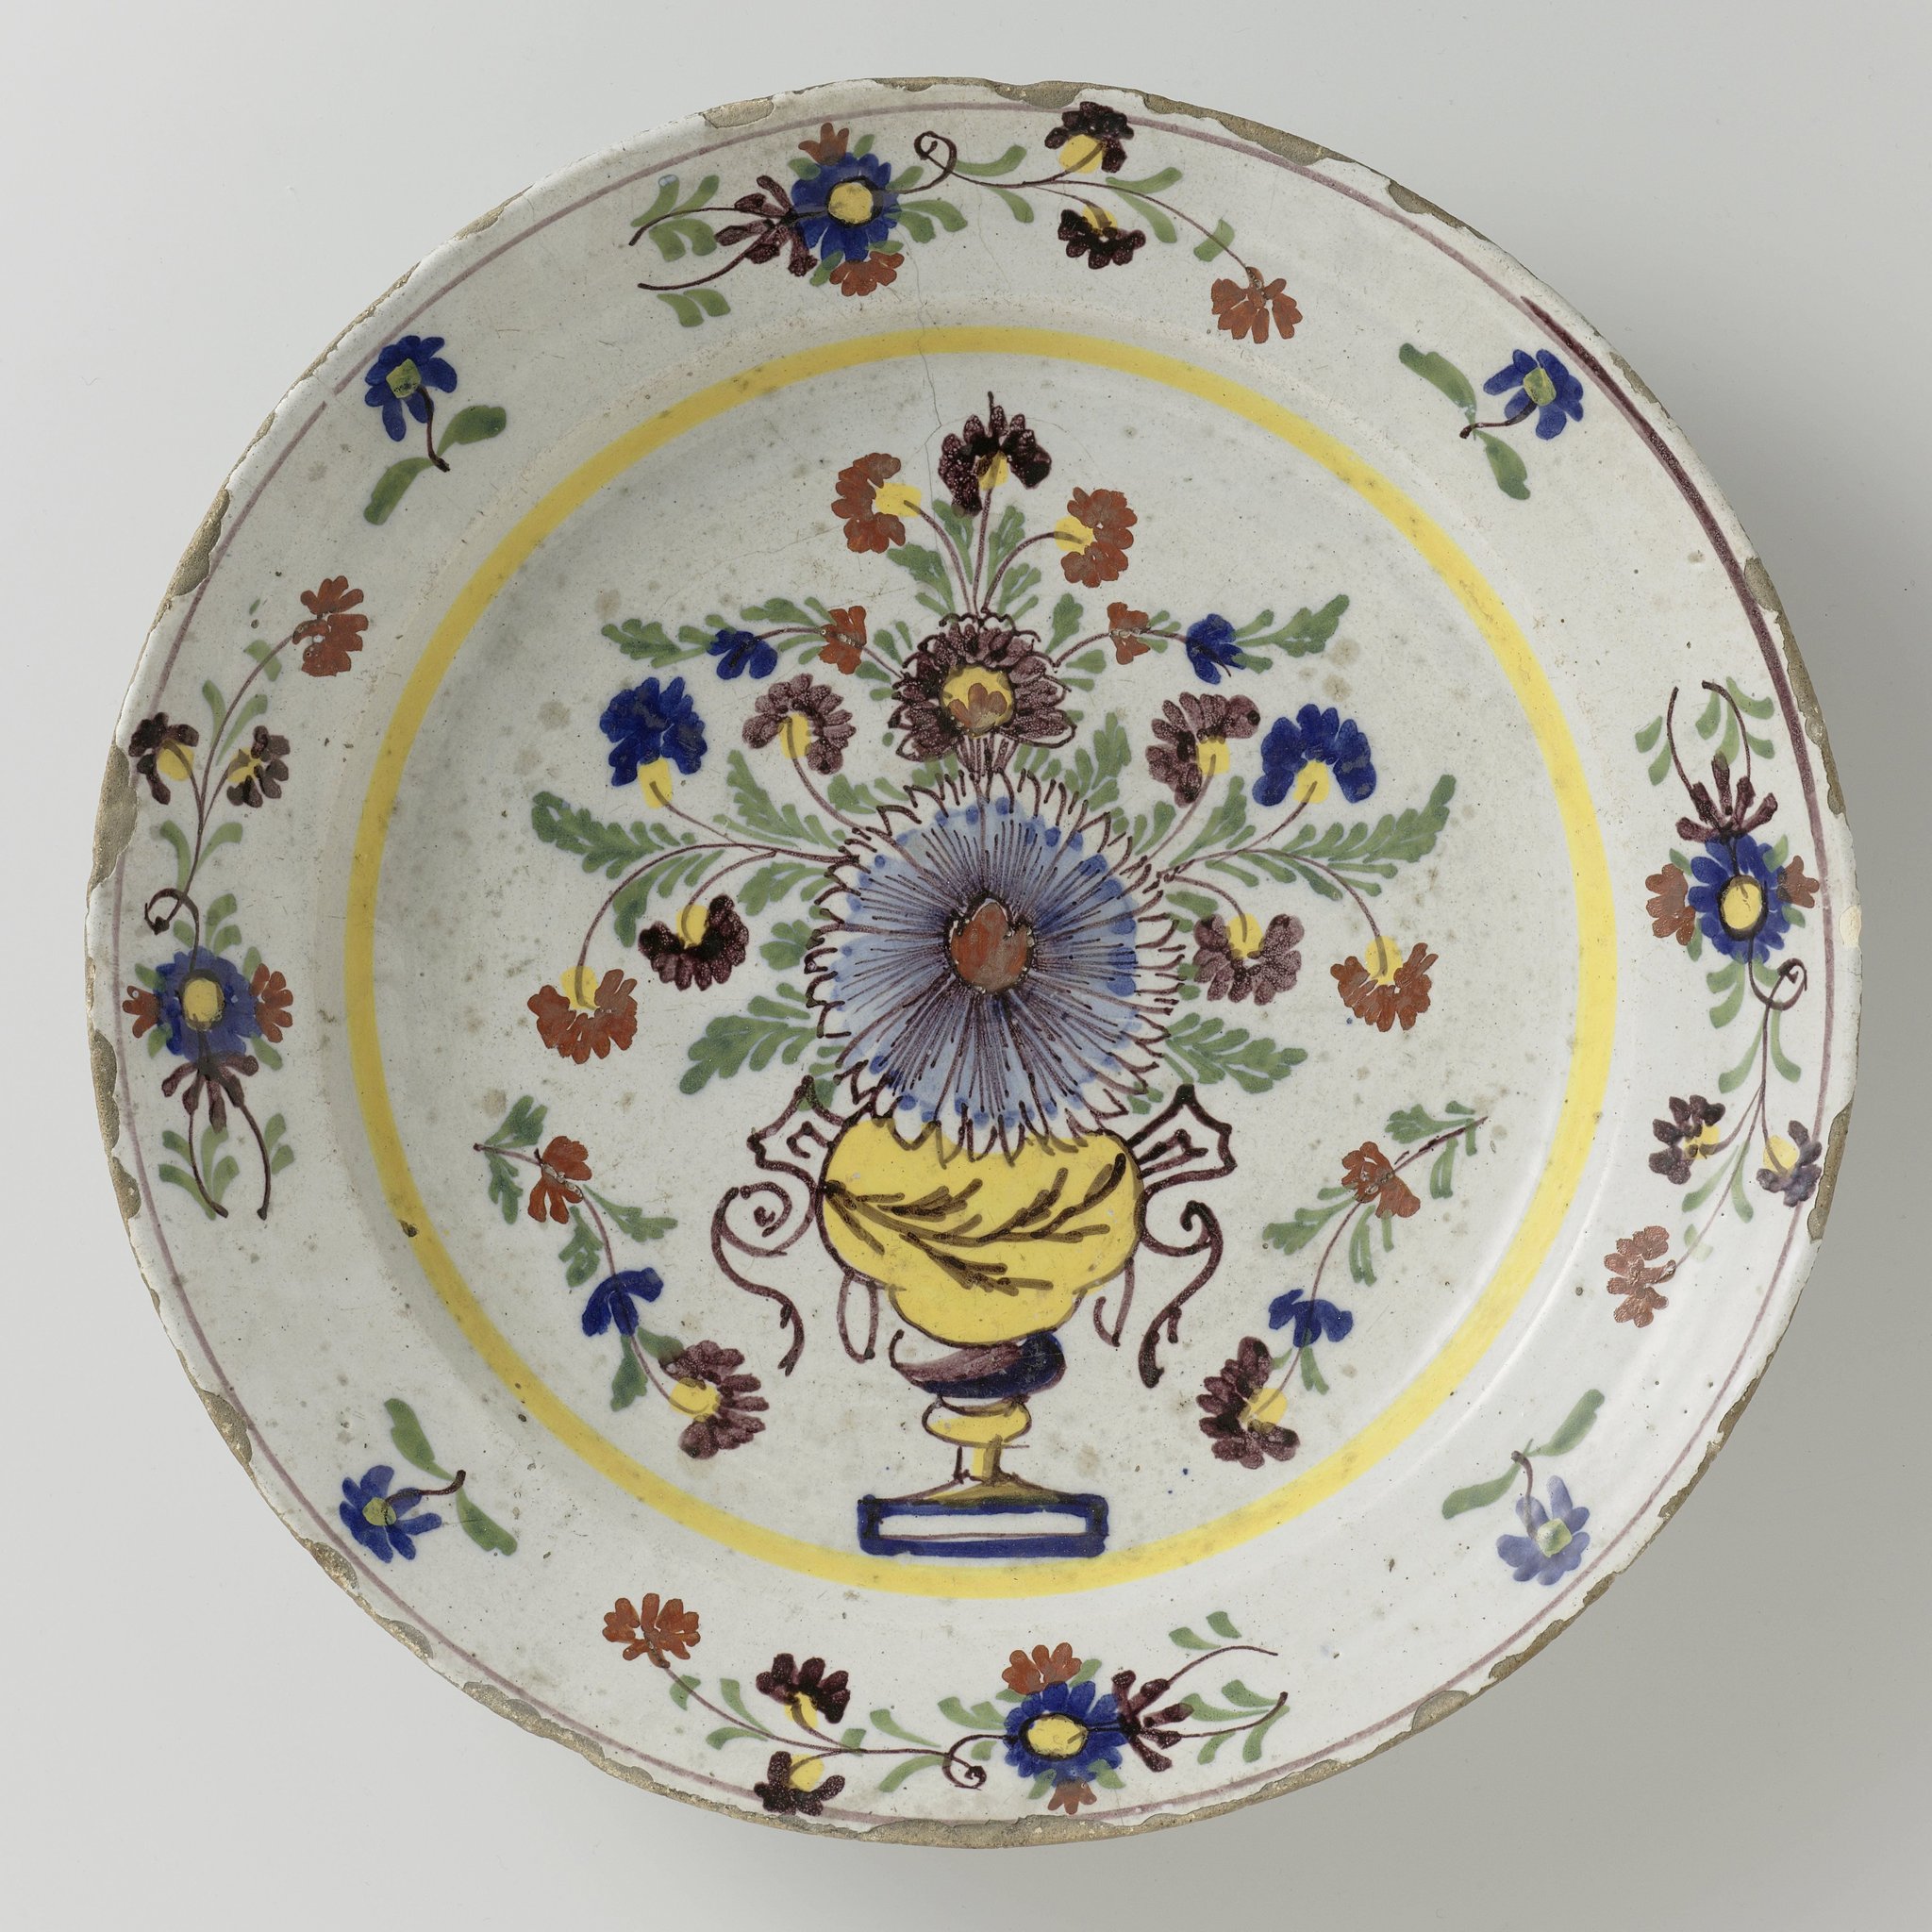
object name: platter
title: Schotel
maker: Anonymous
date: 1770-1820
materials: earthenware, glaze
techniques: painted, polychromy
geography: delft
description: Ronde schotel van veelkleurig beschilderde faience. Op het plat is een vaas met bloemen en op de rand zijn vier bloemenranken geschilderd. Bij de schotel hoort een identieke schotel met invnr. BK-NM-13354-b.